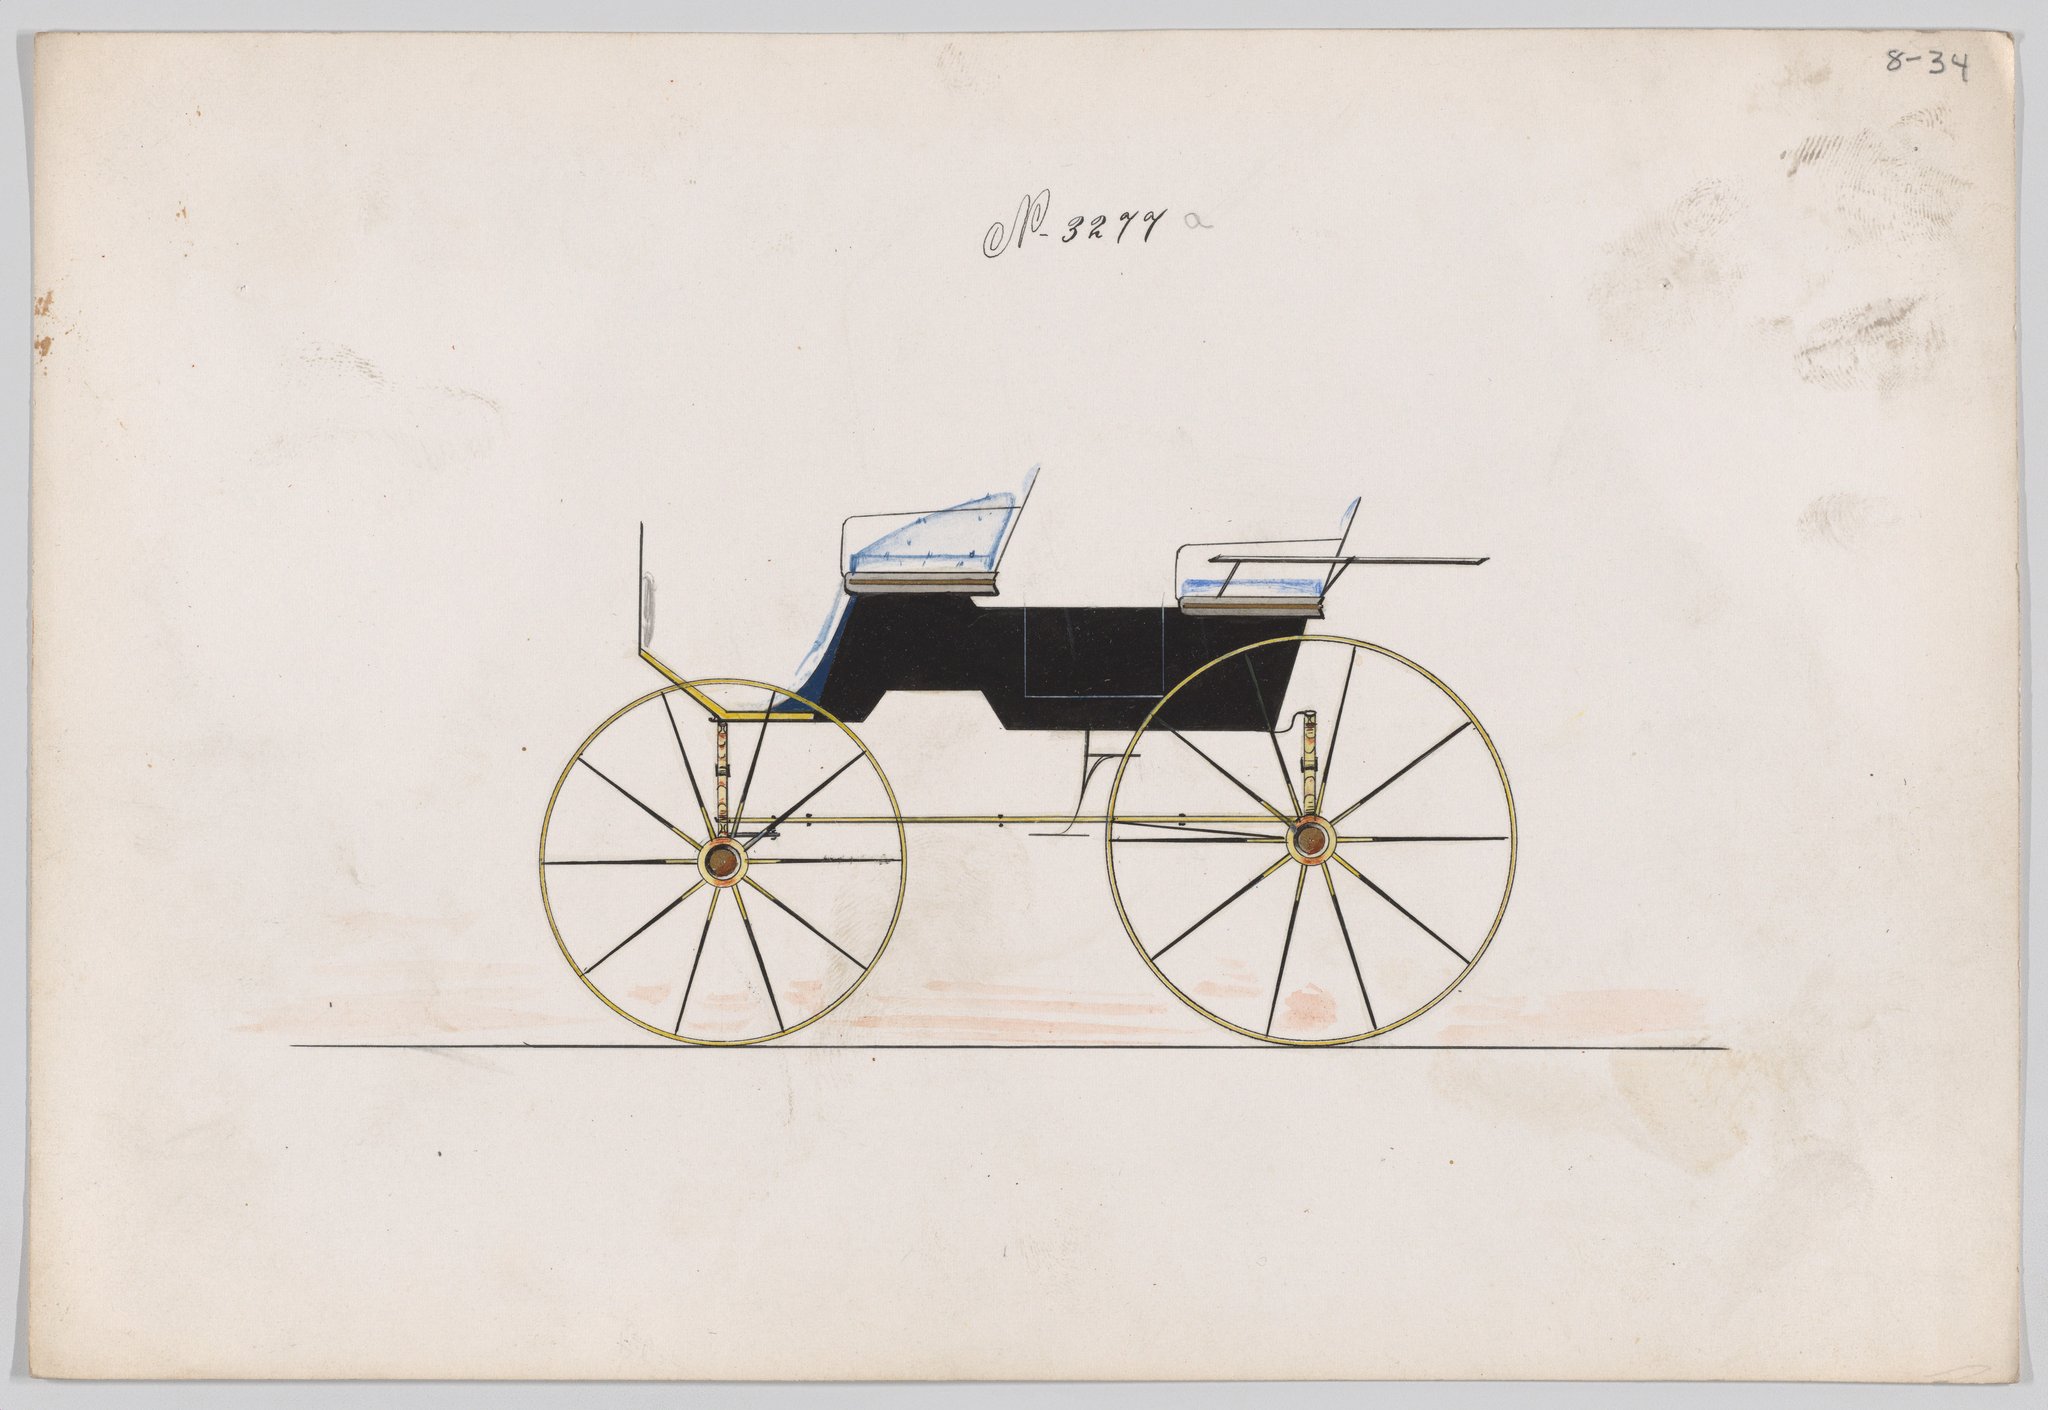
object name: drawing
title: Design for 4 seat Phaeton, no top, no. 3277a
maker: brewster & co.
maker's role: manufacturer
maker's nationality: american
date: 1876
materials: gouache, gum arabic, ink, watercolor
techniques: pen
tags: carriages